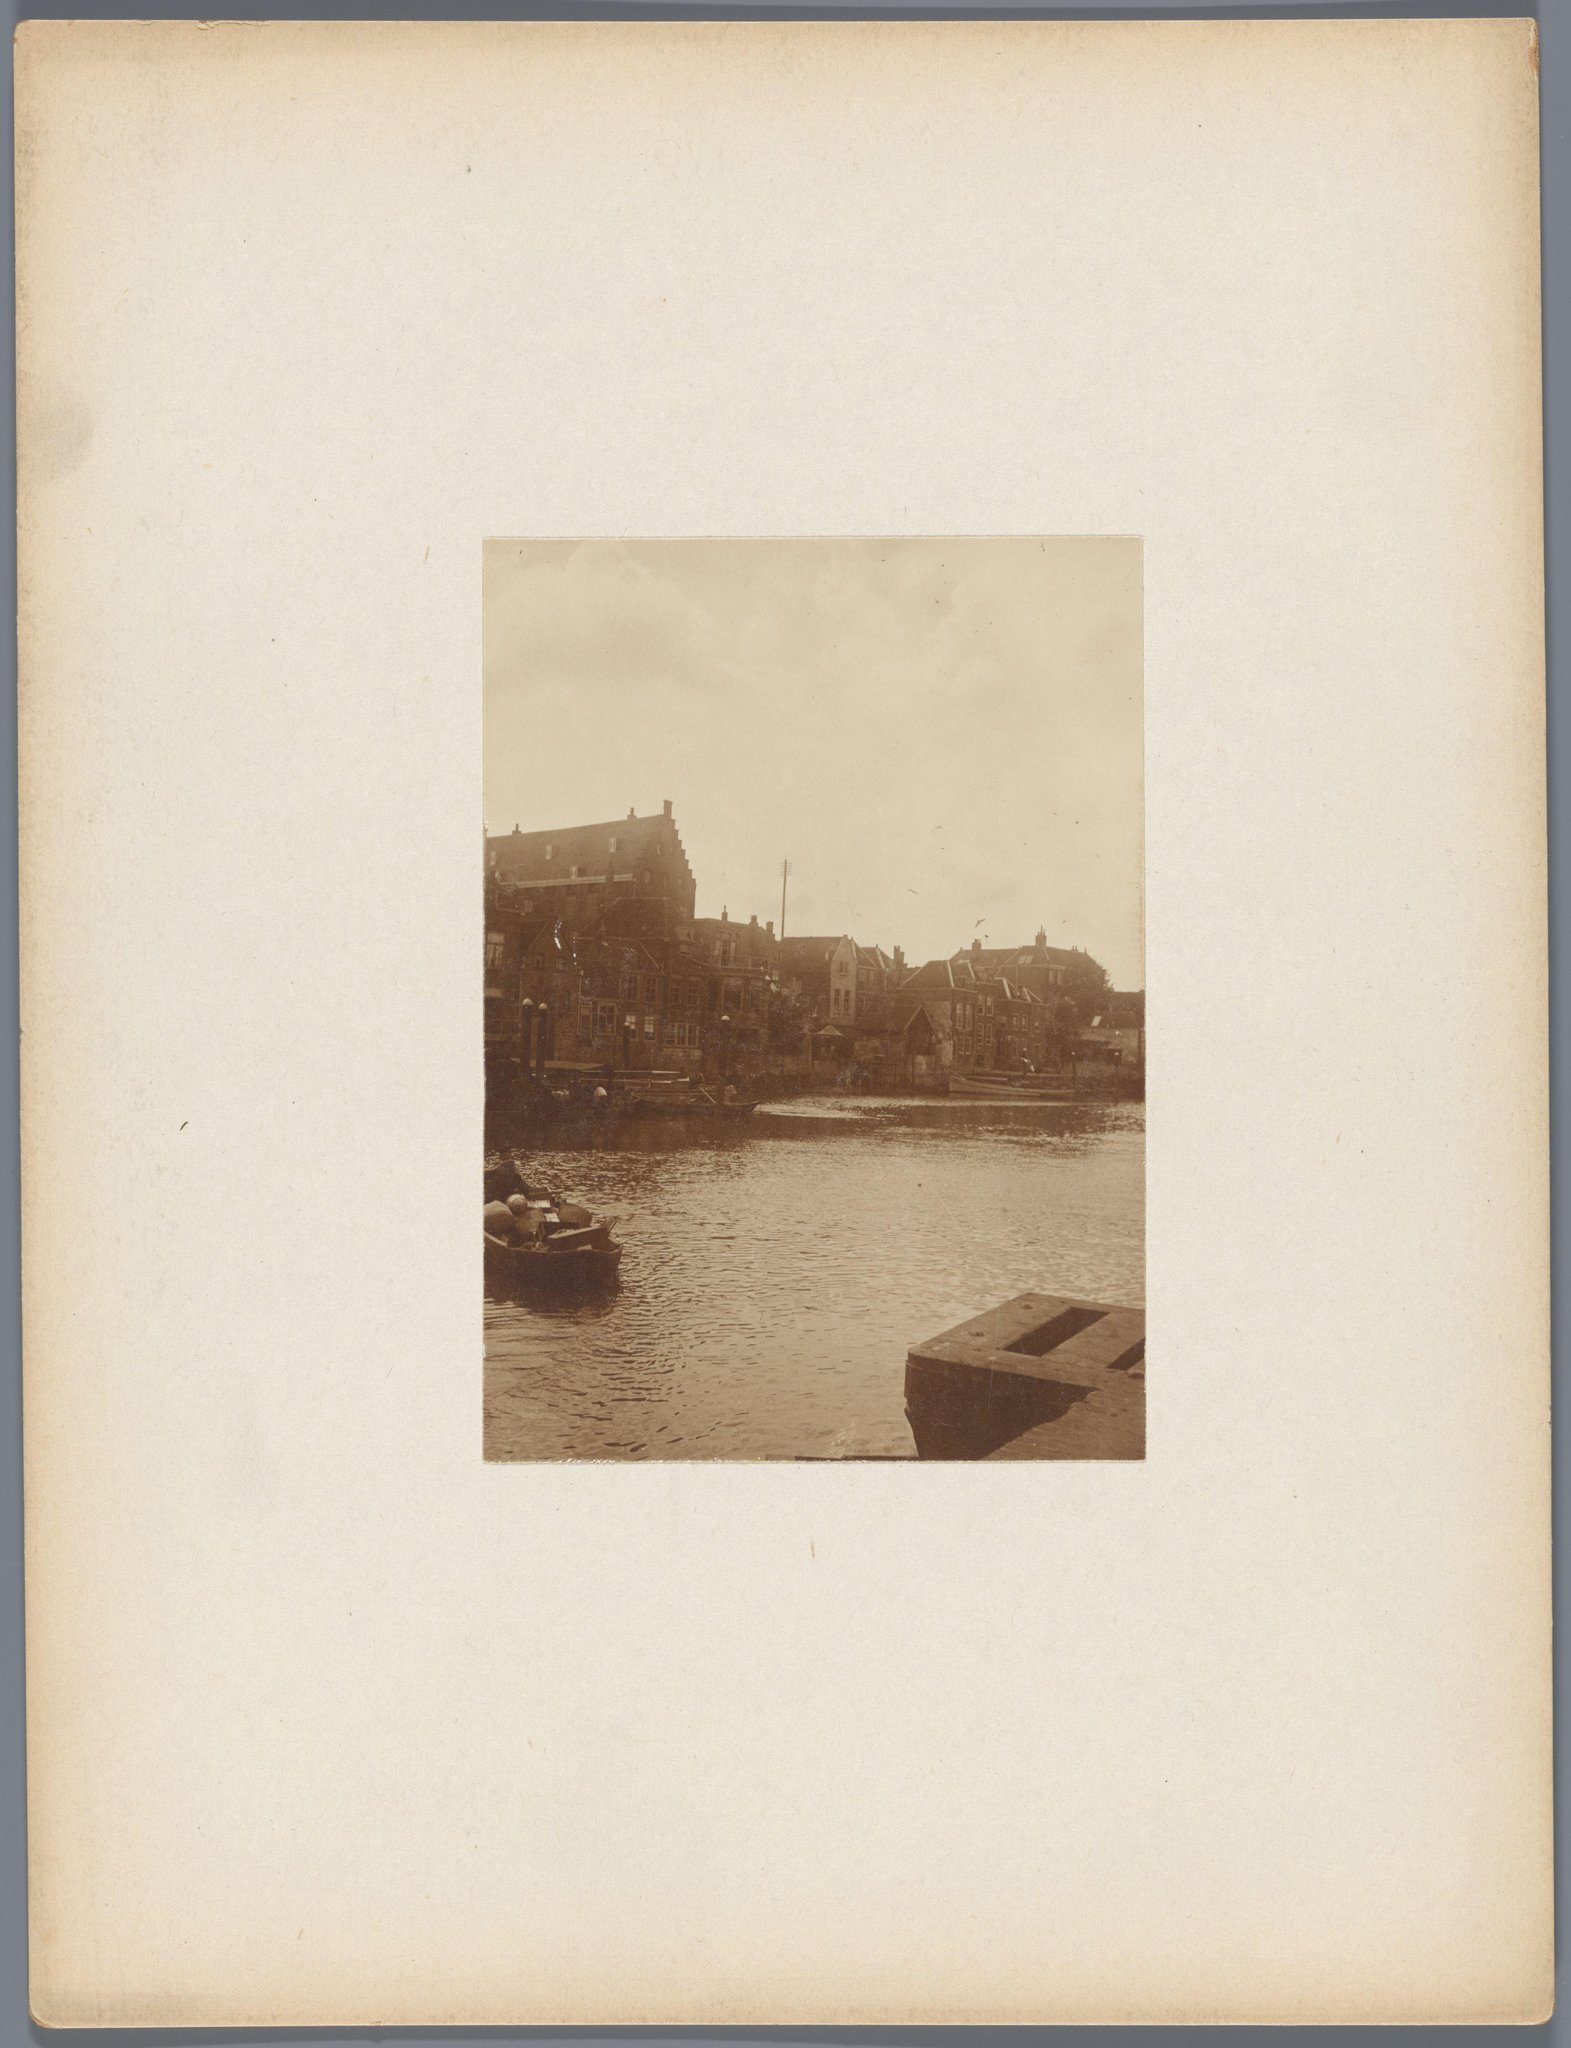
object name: photograph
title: Gebouwen aan het water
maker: Anonymous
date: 1907-1910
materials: cardboard, photographic support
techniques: collodion silver print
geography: netherlands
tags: canals, waters (in city) (+ city(-scape) with figures, staffage), netherlands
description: Gebouwen aan het water. Onderdeel van het losbladige fotoalbum met 39 foto's van een reis door Nederland, ca. 1907-1910.